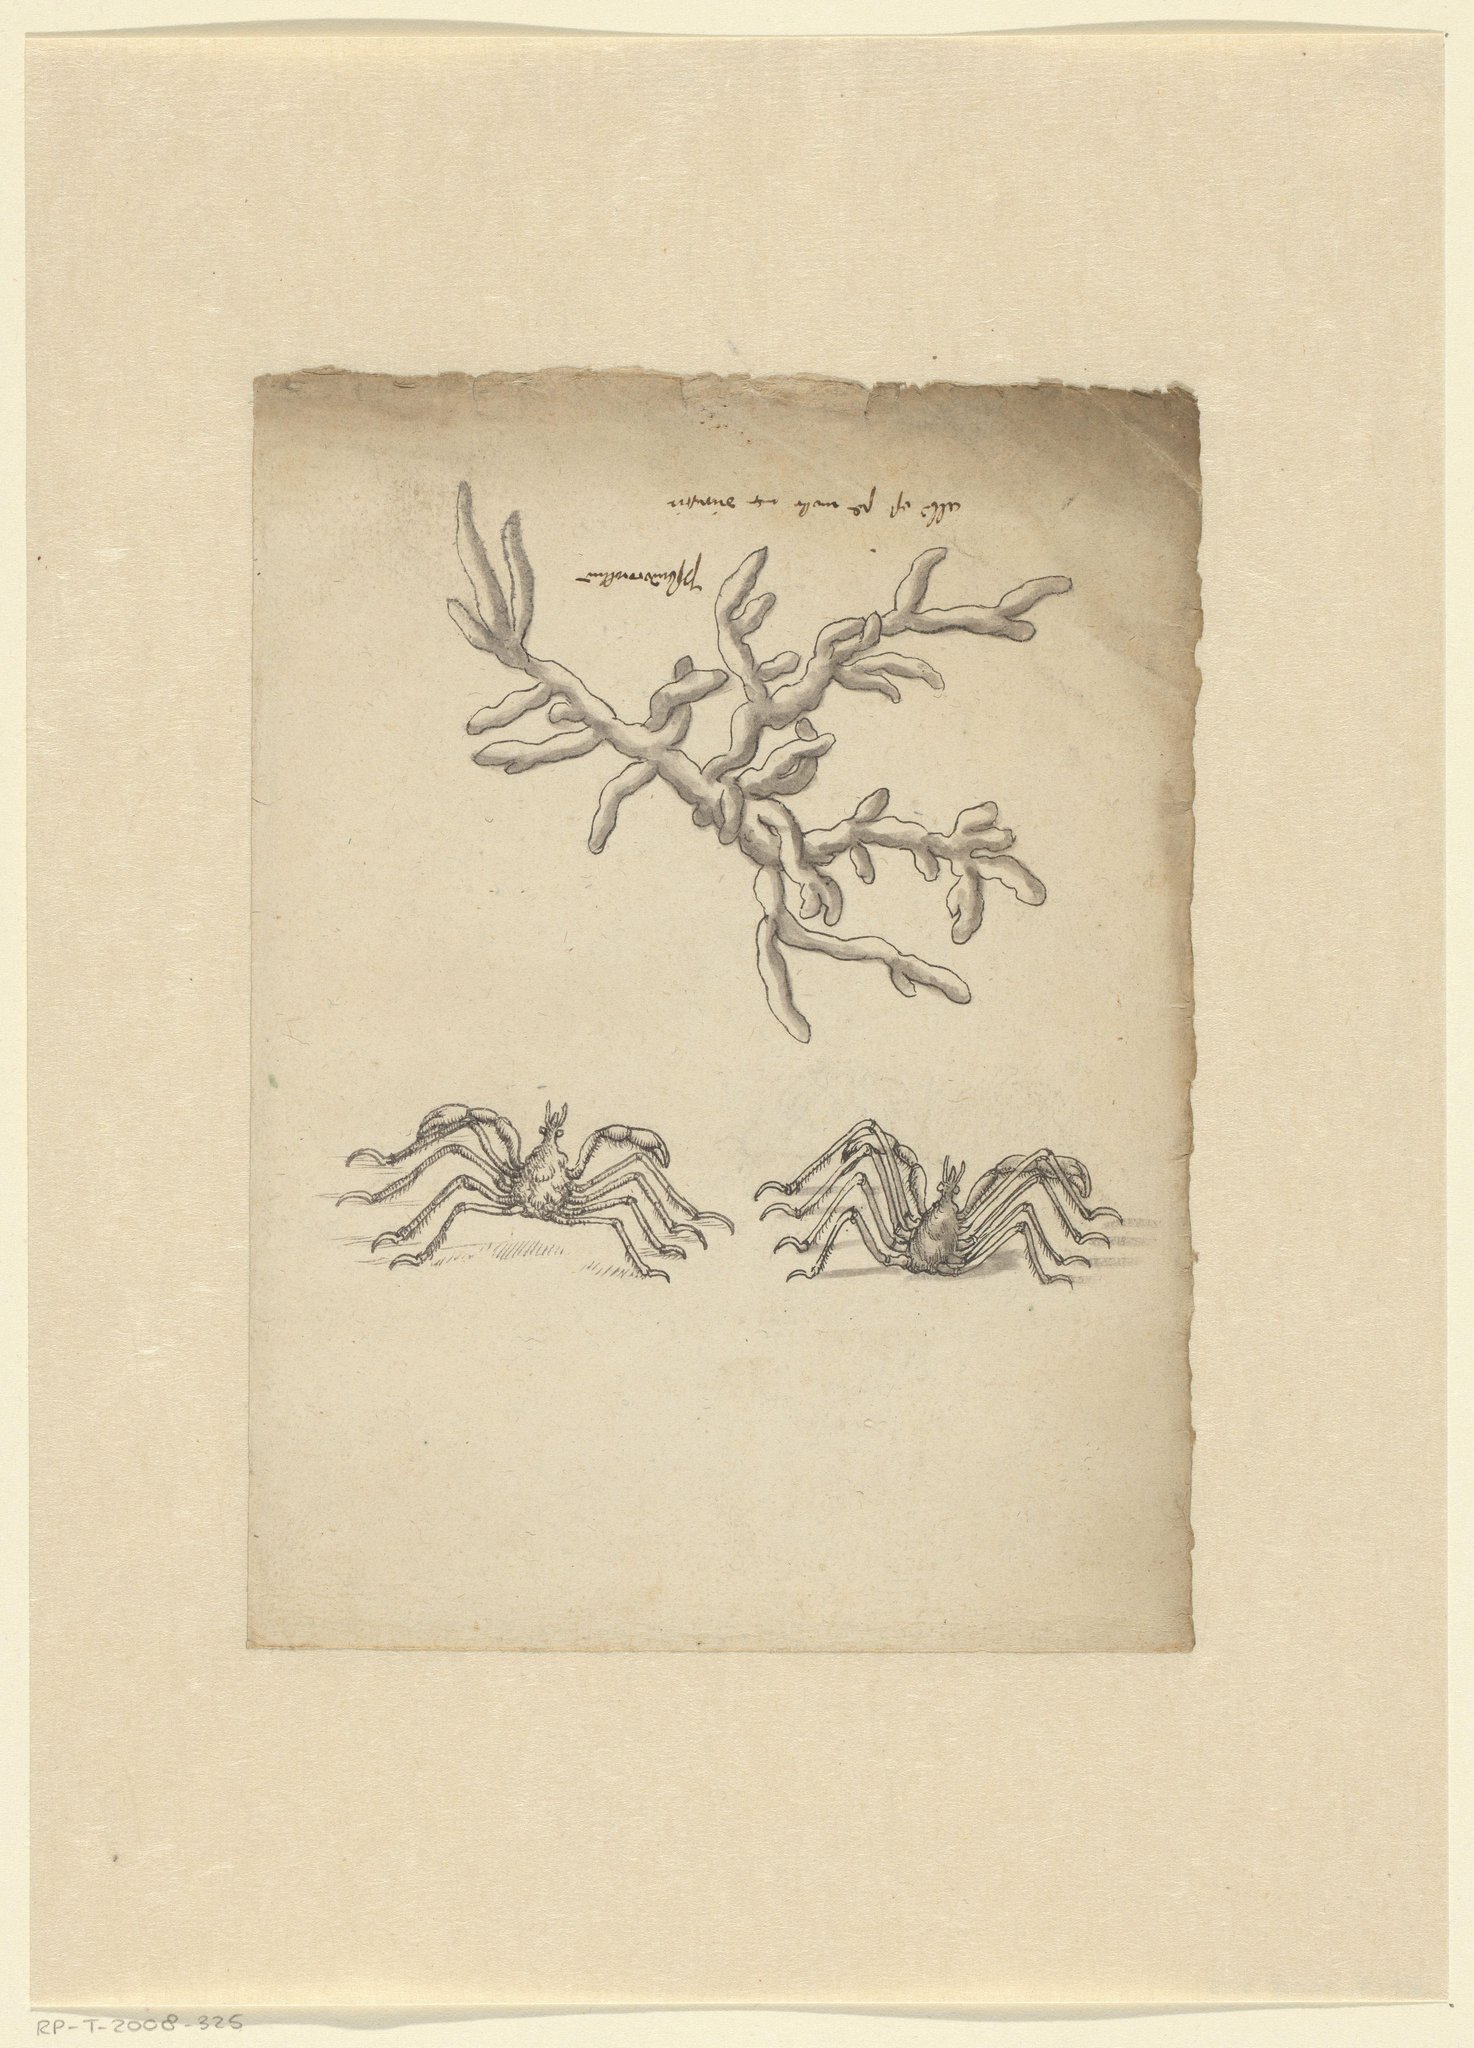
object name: drawing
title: Studies of a pseudo-coral (Alcyonidium Gelatinosum) and two crabs (Stenorhynchus rostratus)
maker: Anonymous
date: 1575-1599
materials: ink, paper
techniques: brush, pen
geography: netherlands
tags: coelenterata: coral, crustaceans: crab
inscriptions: inscription: ‘Pseudocoralliū/ albū est sed molle nec durescit’